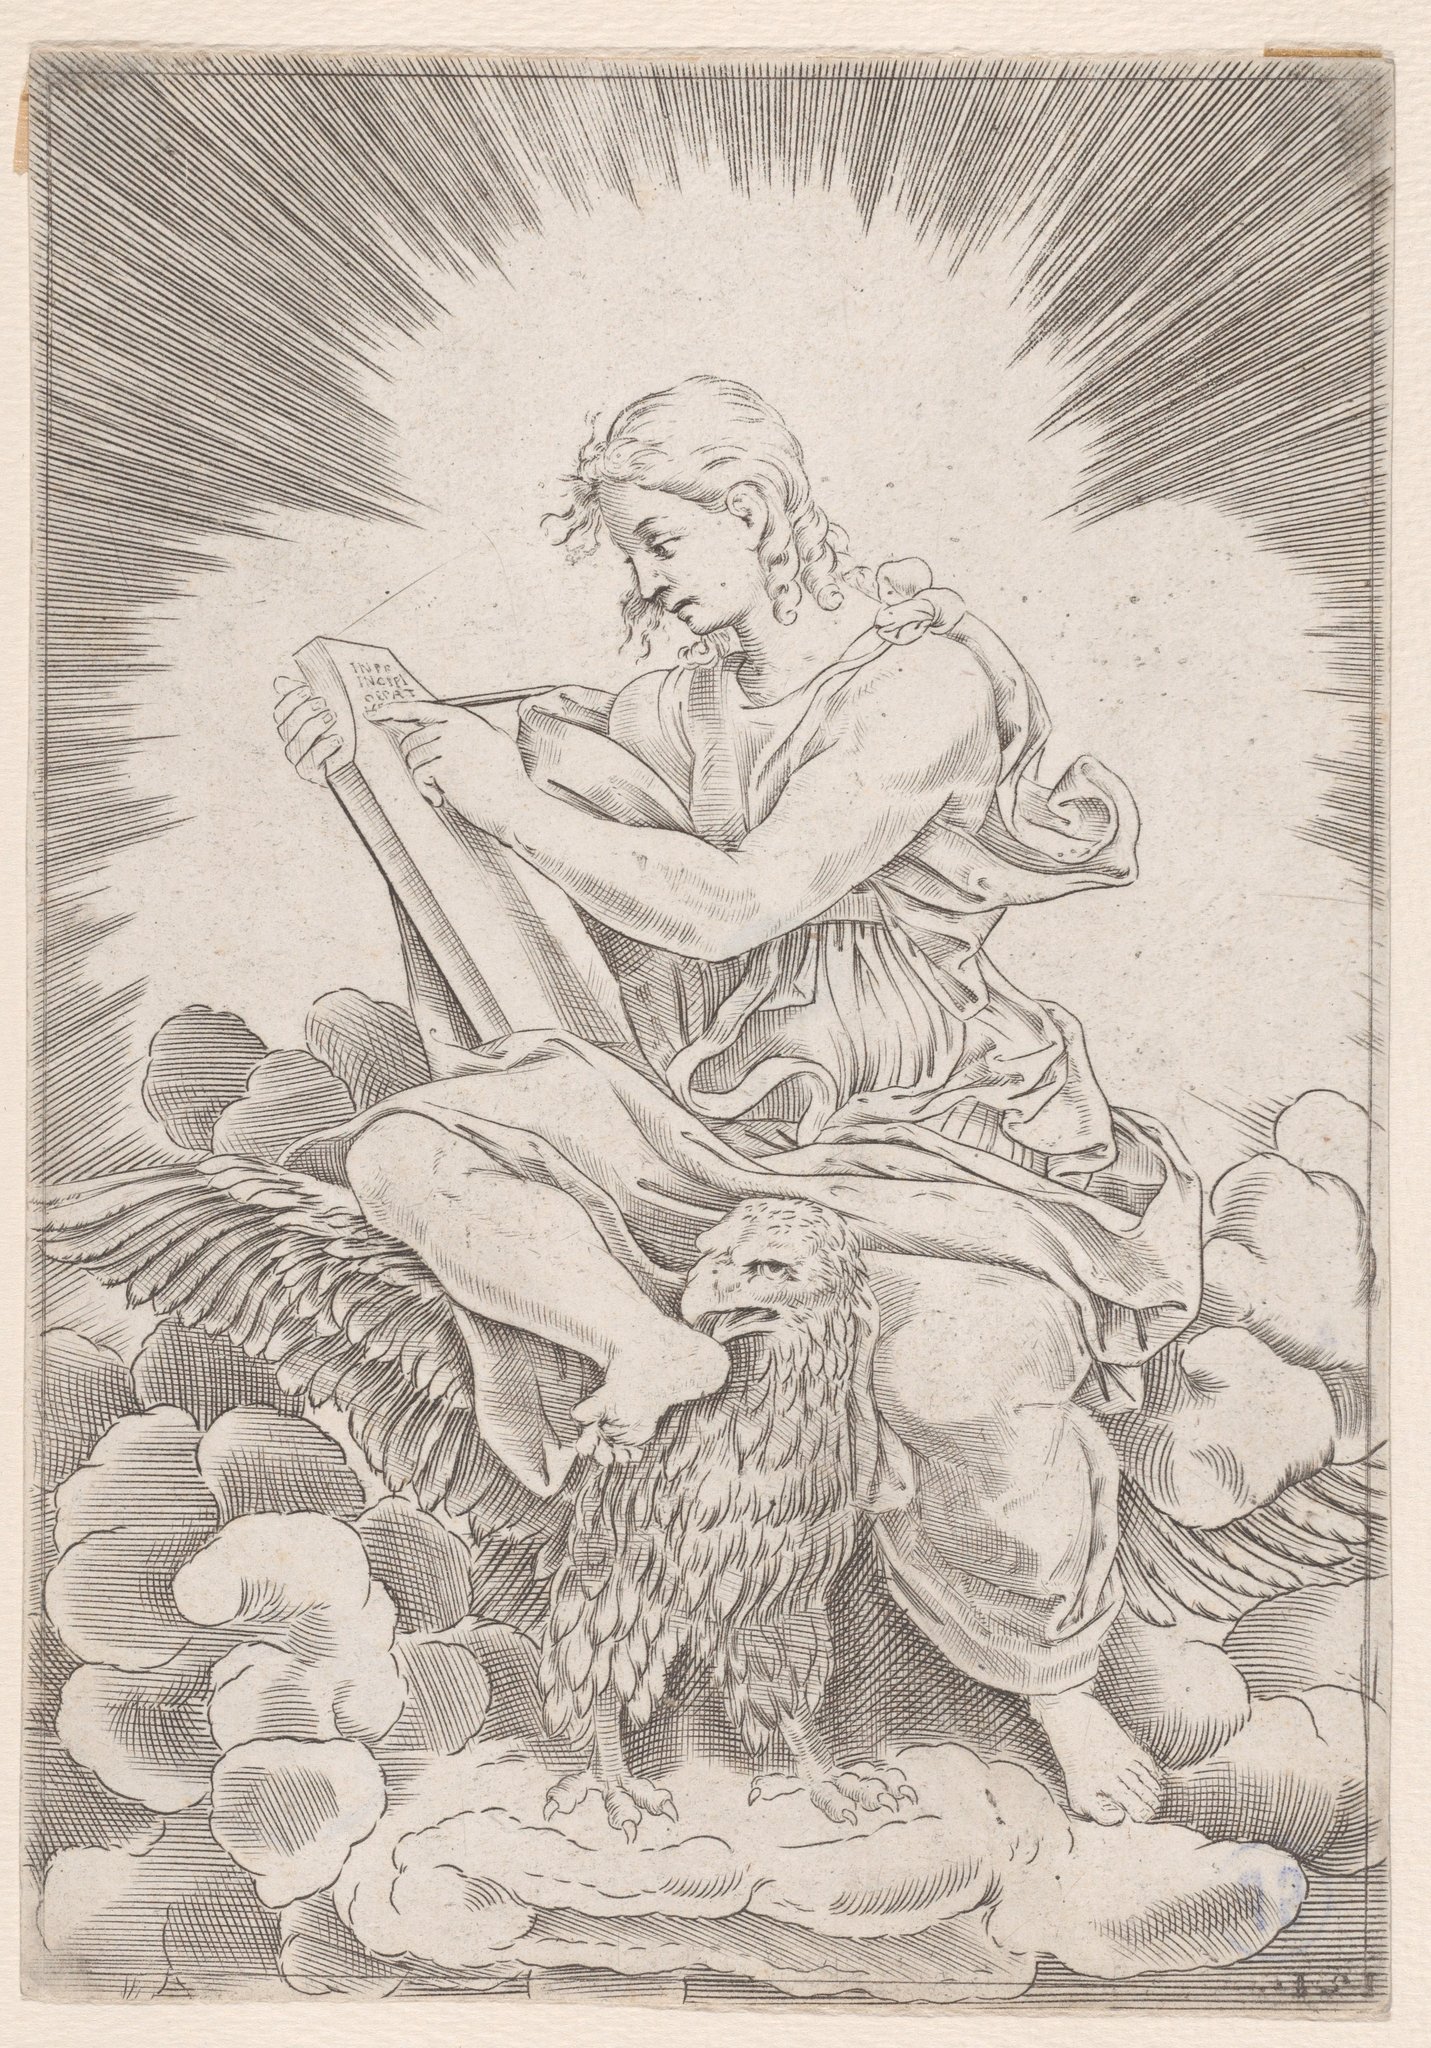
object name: print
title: Saint John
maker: agostino veneziano (agostino dei musi)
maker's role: artist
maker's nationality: italian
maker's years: 1490-1536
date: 1514-1536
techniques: engraving